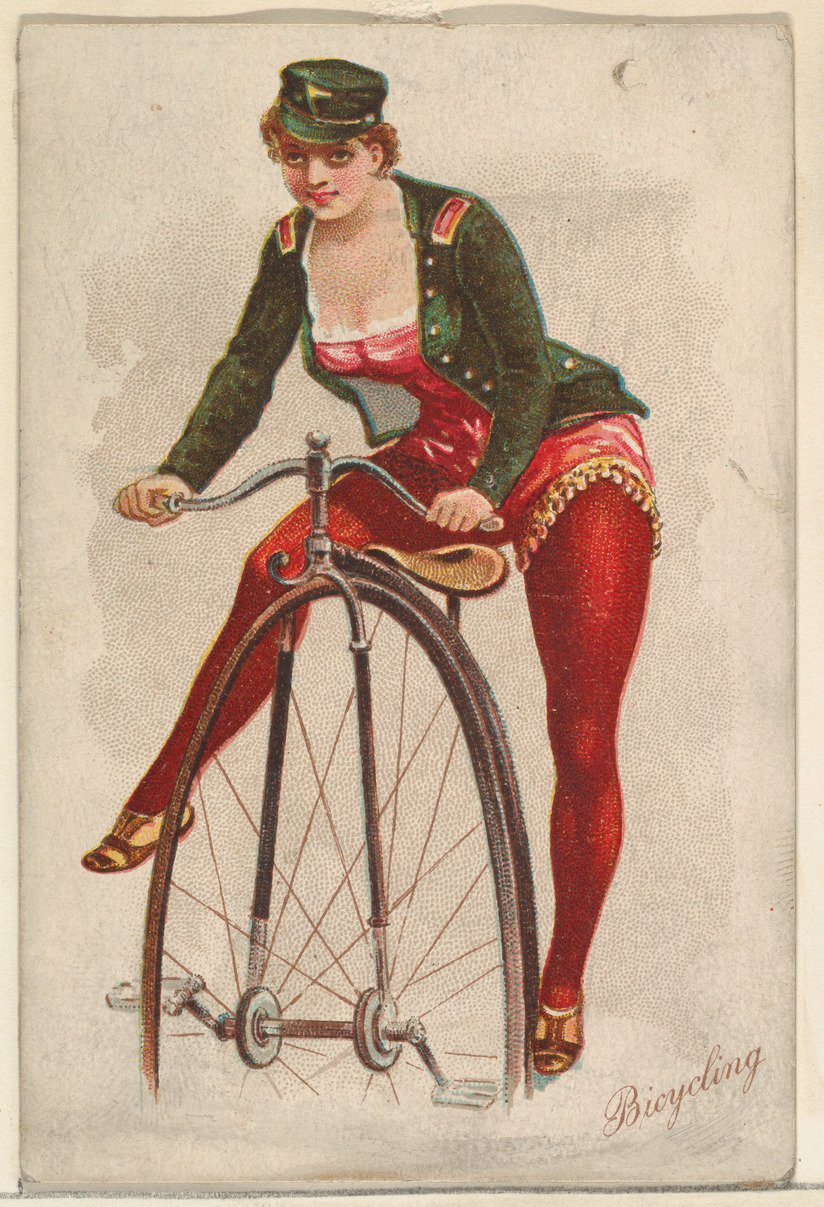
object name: print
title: Bicycling, from the Pretty Athletes series (N196) issued by Wm. S. Kimball & Co.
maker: william s. kimball & company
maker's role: publisher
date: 1889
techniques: color lithograph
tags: women,athletes,bicycles